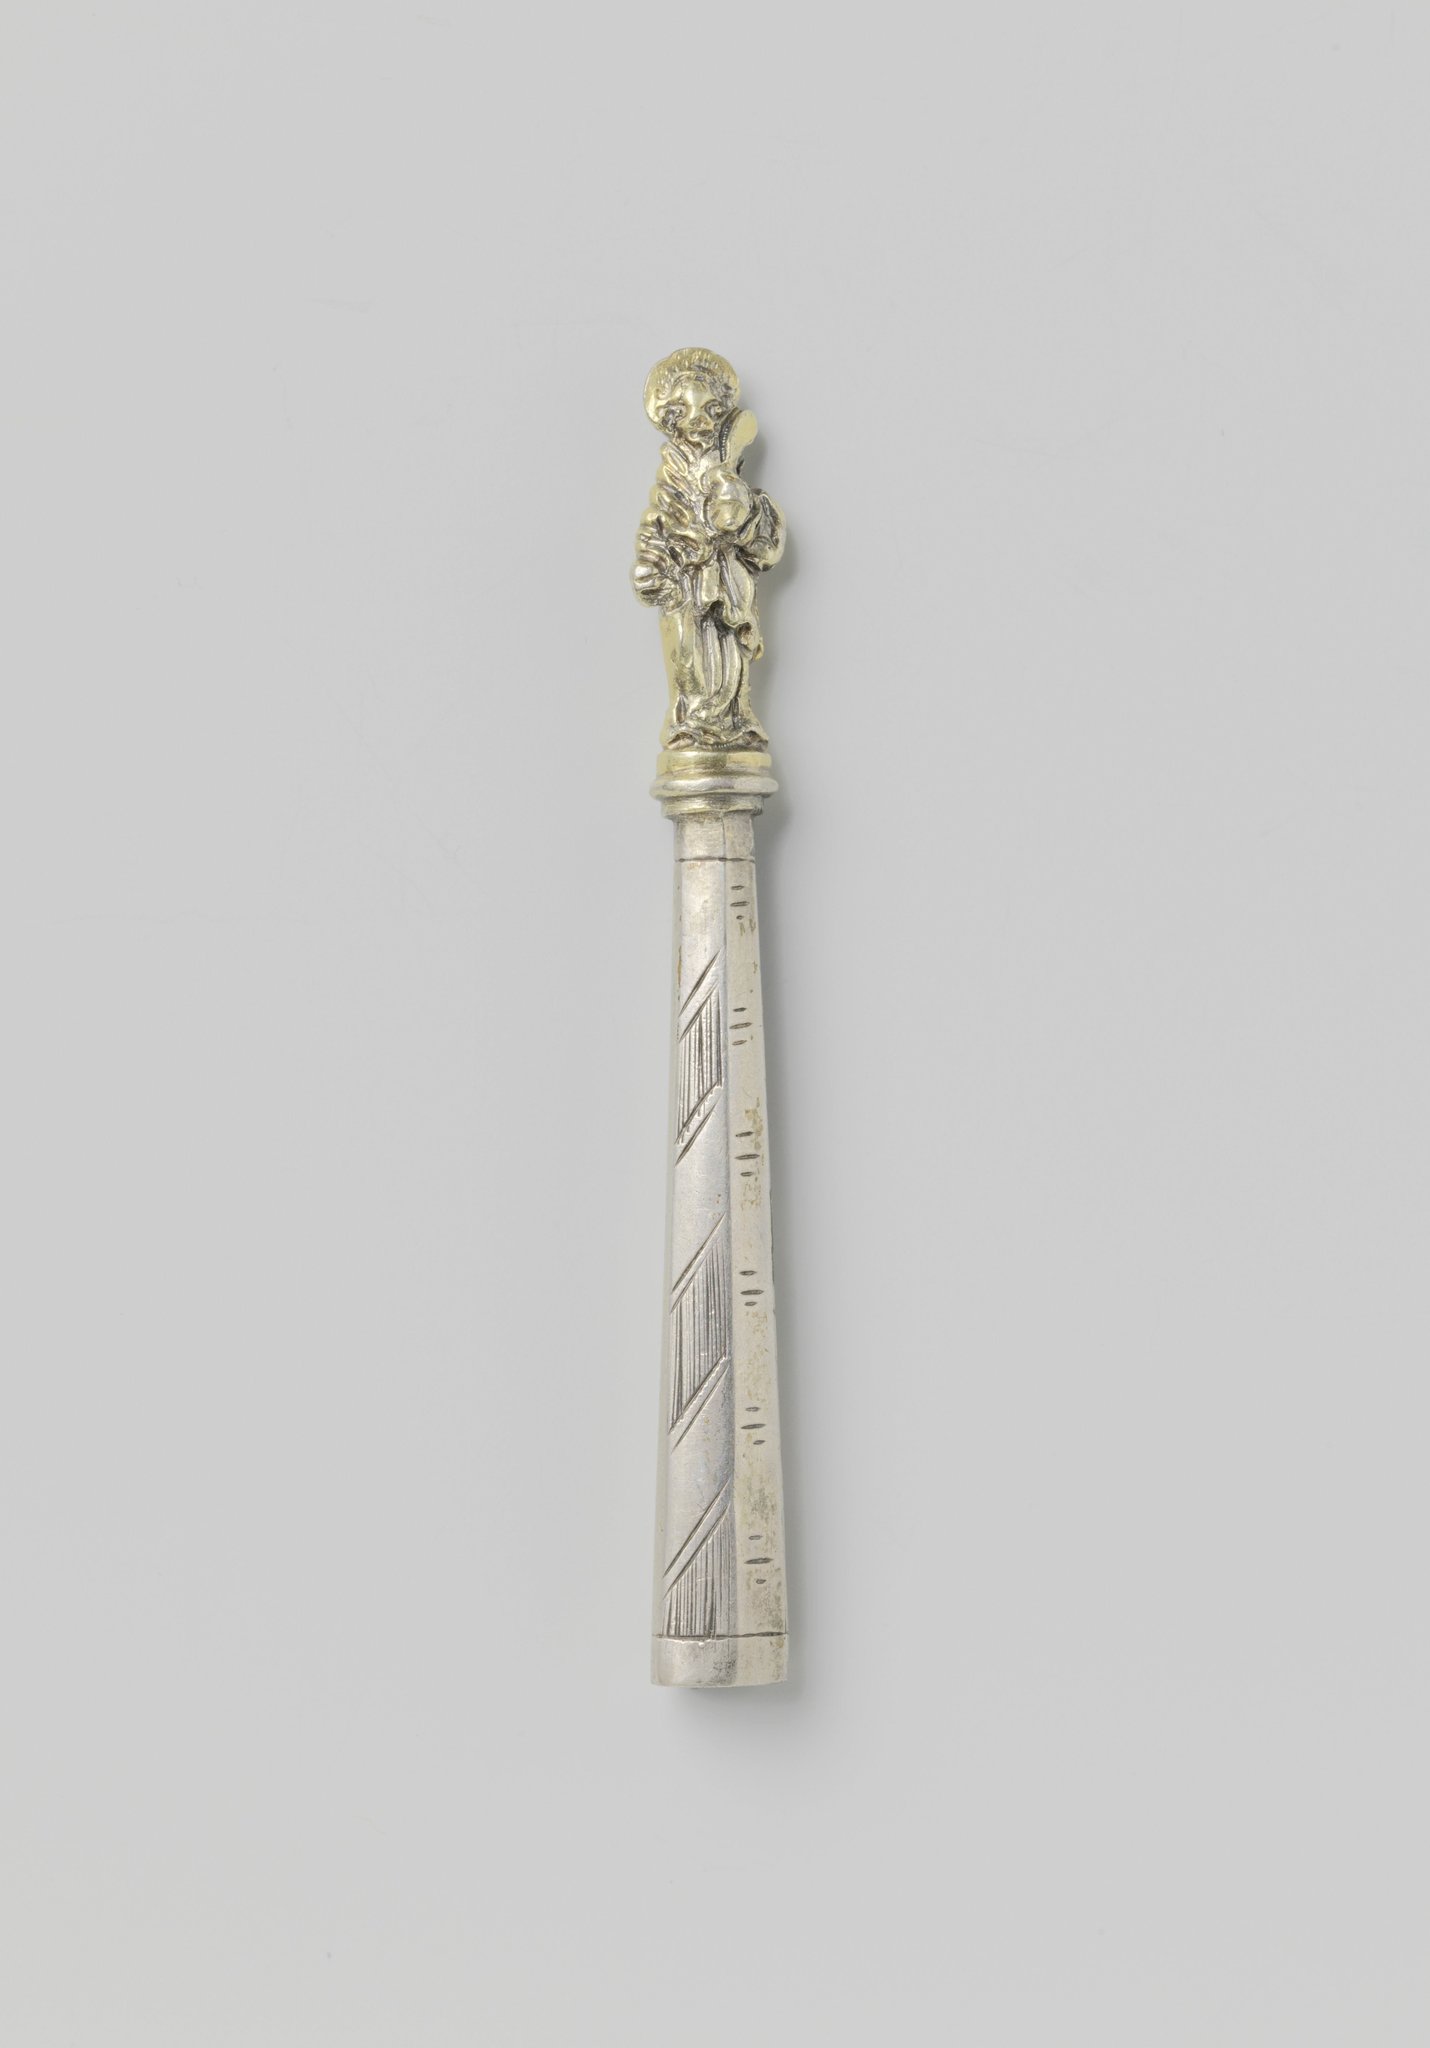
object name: lepelsteel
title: Lepelsteel met beeltenis apostel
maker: Anonymous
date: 1600-1625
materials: silver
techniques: gilding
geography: germany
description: Lepelsteel van zilver met aan het uiteinde een vergulde apostel.